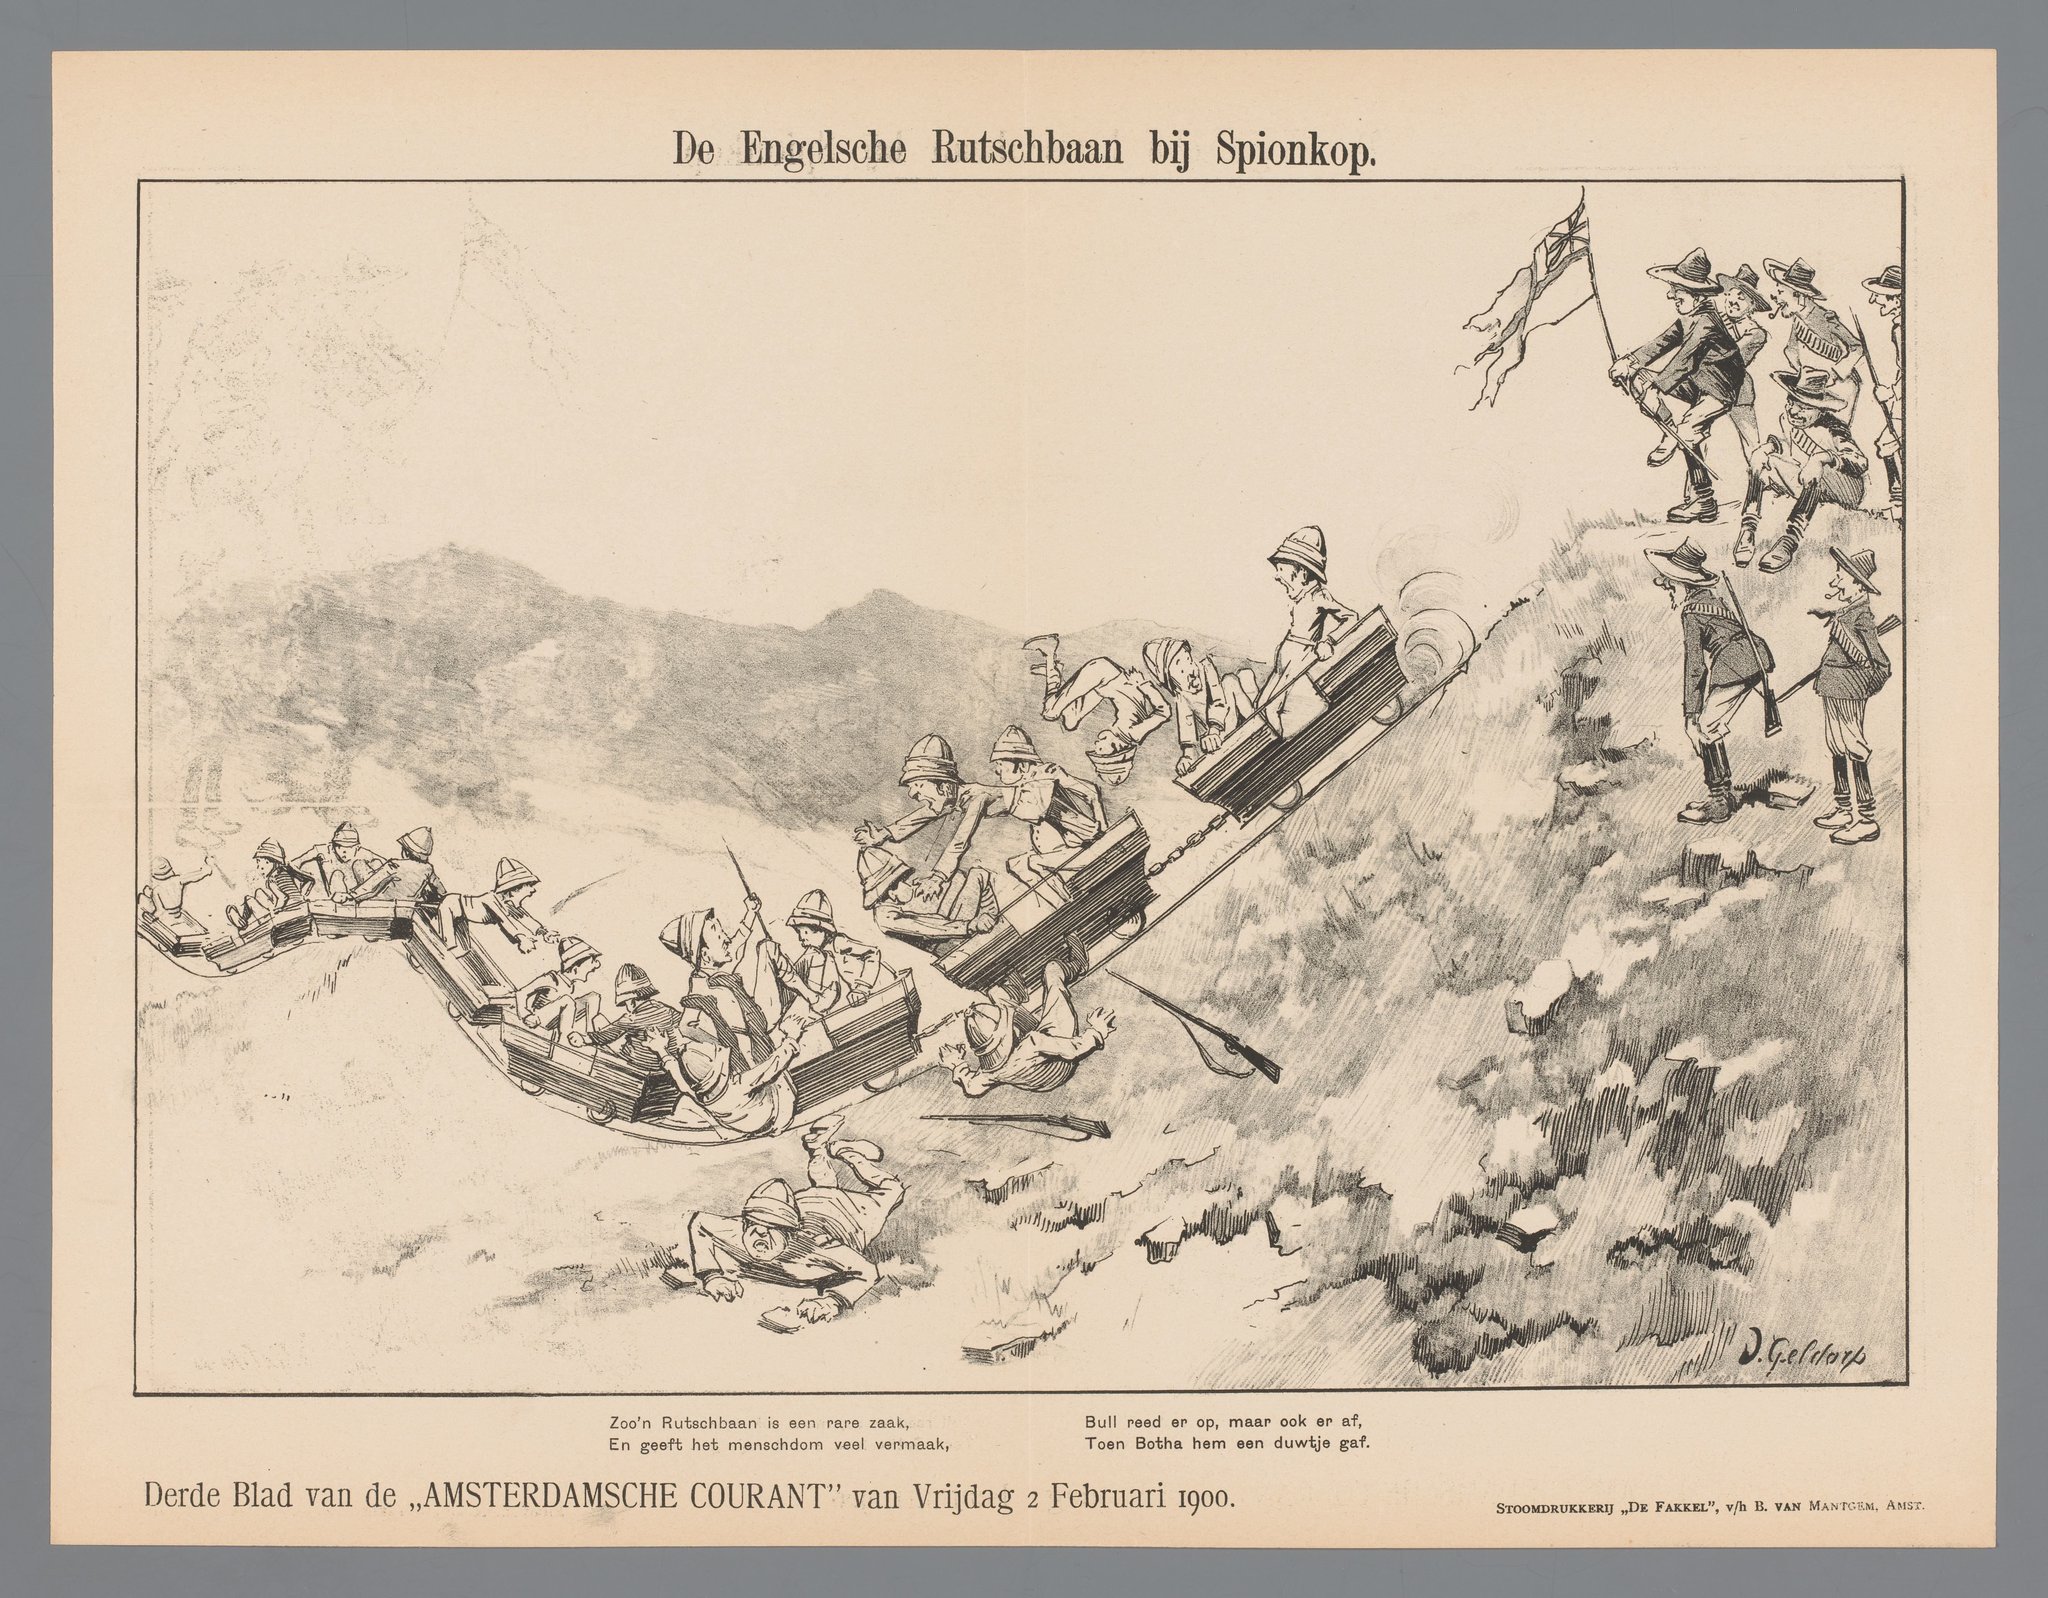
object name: cartoon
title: De Engelschen Rutschbaan bij Spionkop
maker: petrus van geldorp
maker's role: draughtsman, print maker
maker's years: 1872-1939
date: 1900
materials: paper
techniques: lithograph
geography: amsterdam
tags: politician, e.g. party leader, political caricatures and satires, playground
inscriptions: date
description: Prent uit het bijvoegsel van: De Amsterdamsche Courant, 2 februari 1900.